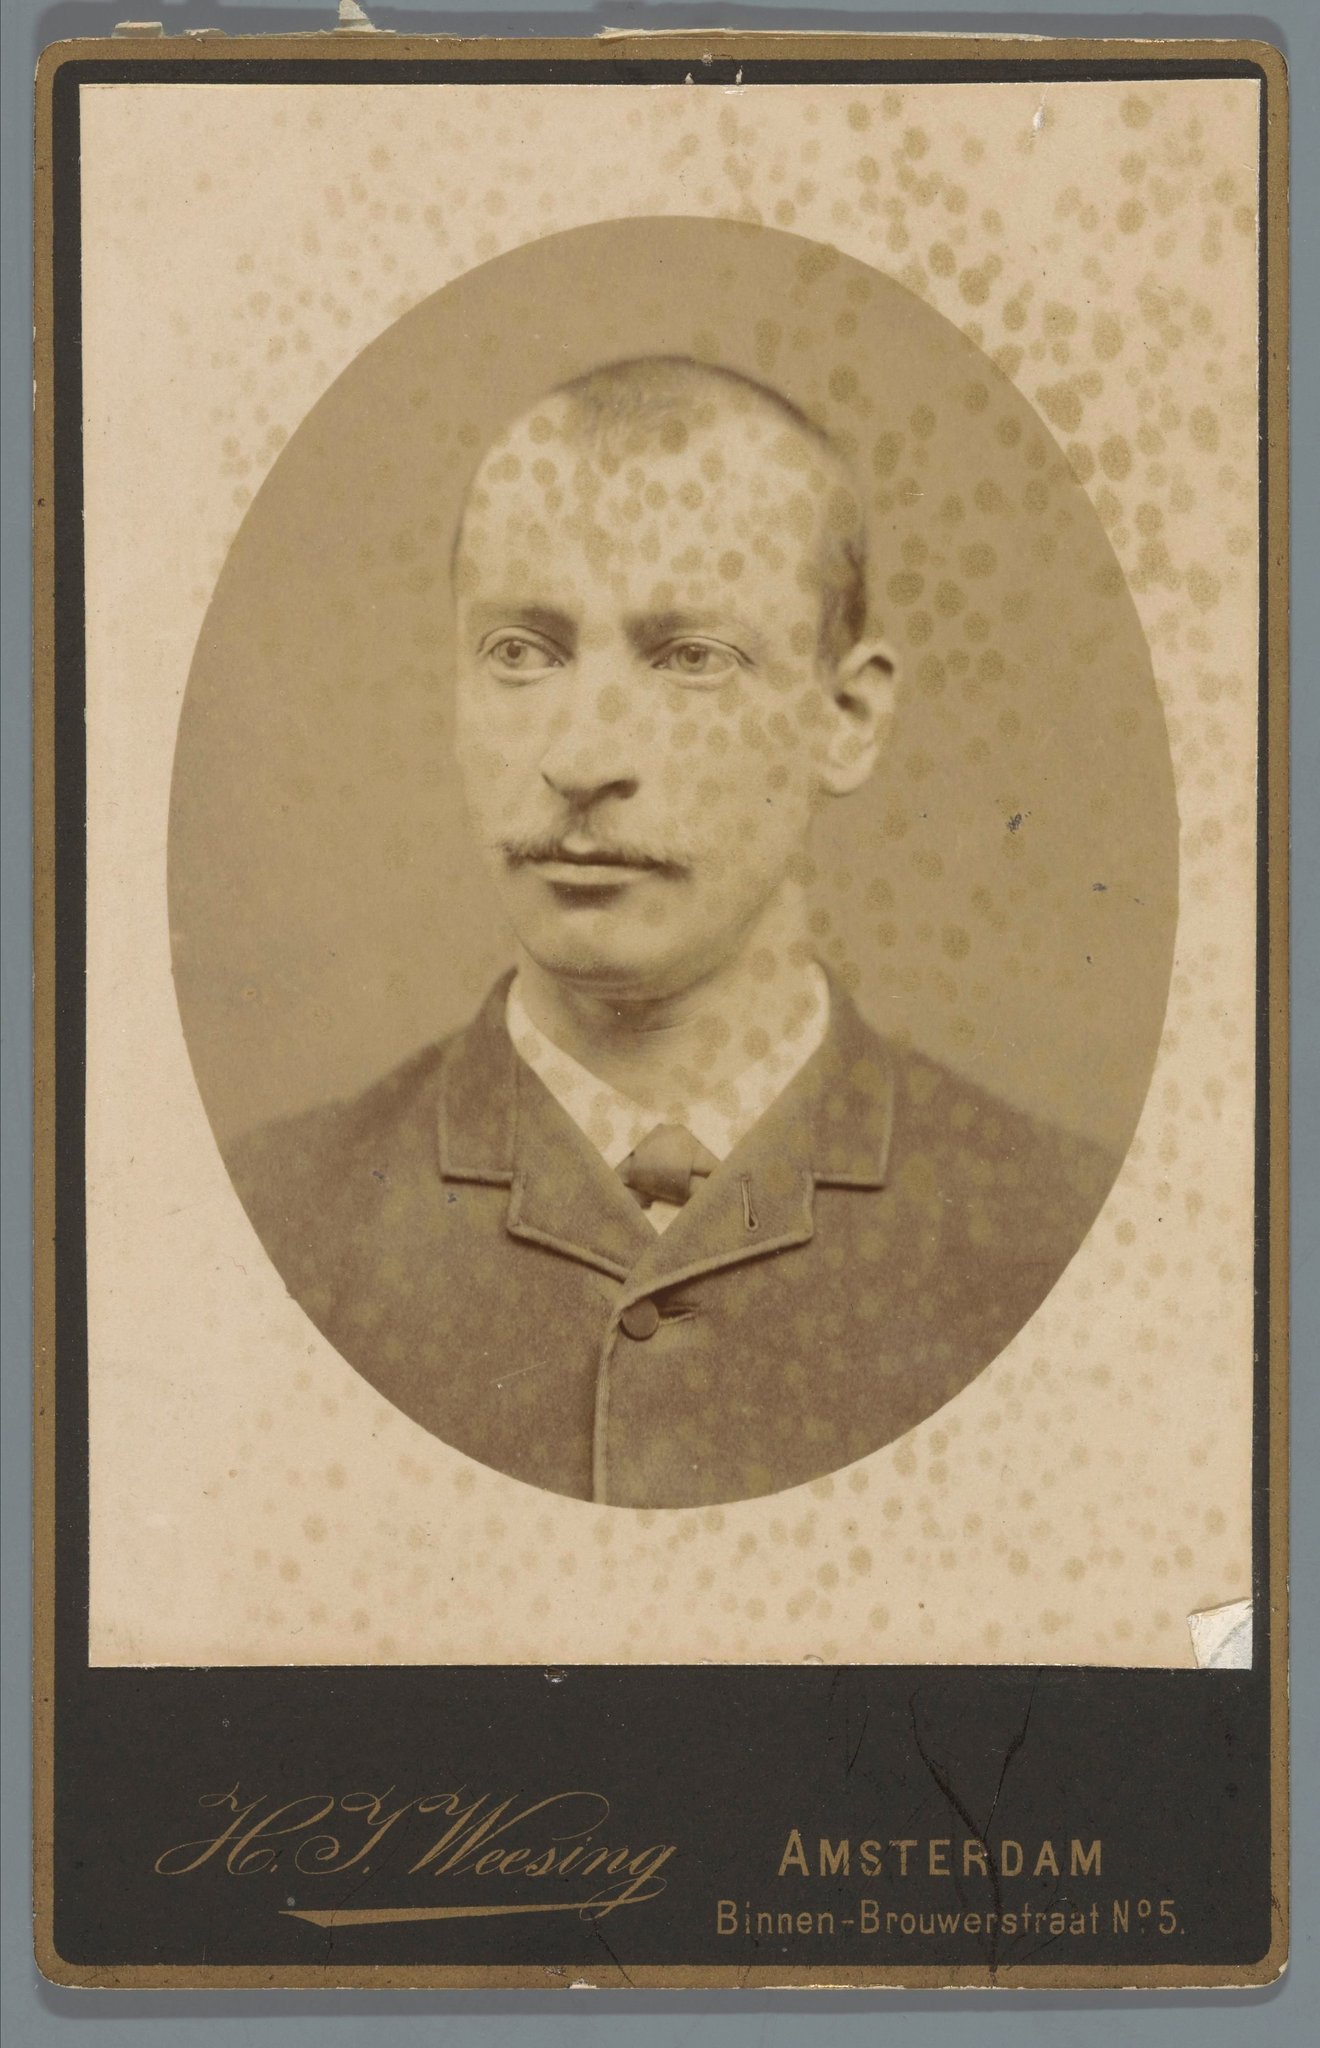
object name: cabinet photograph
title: Portret van een onbekende man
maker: hermanus jodocus weesing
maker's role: fotograaf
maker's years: 1844-1910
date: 1880-1900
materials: cardboard, photographic support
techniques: albumen print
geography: amsterdam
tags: adult man